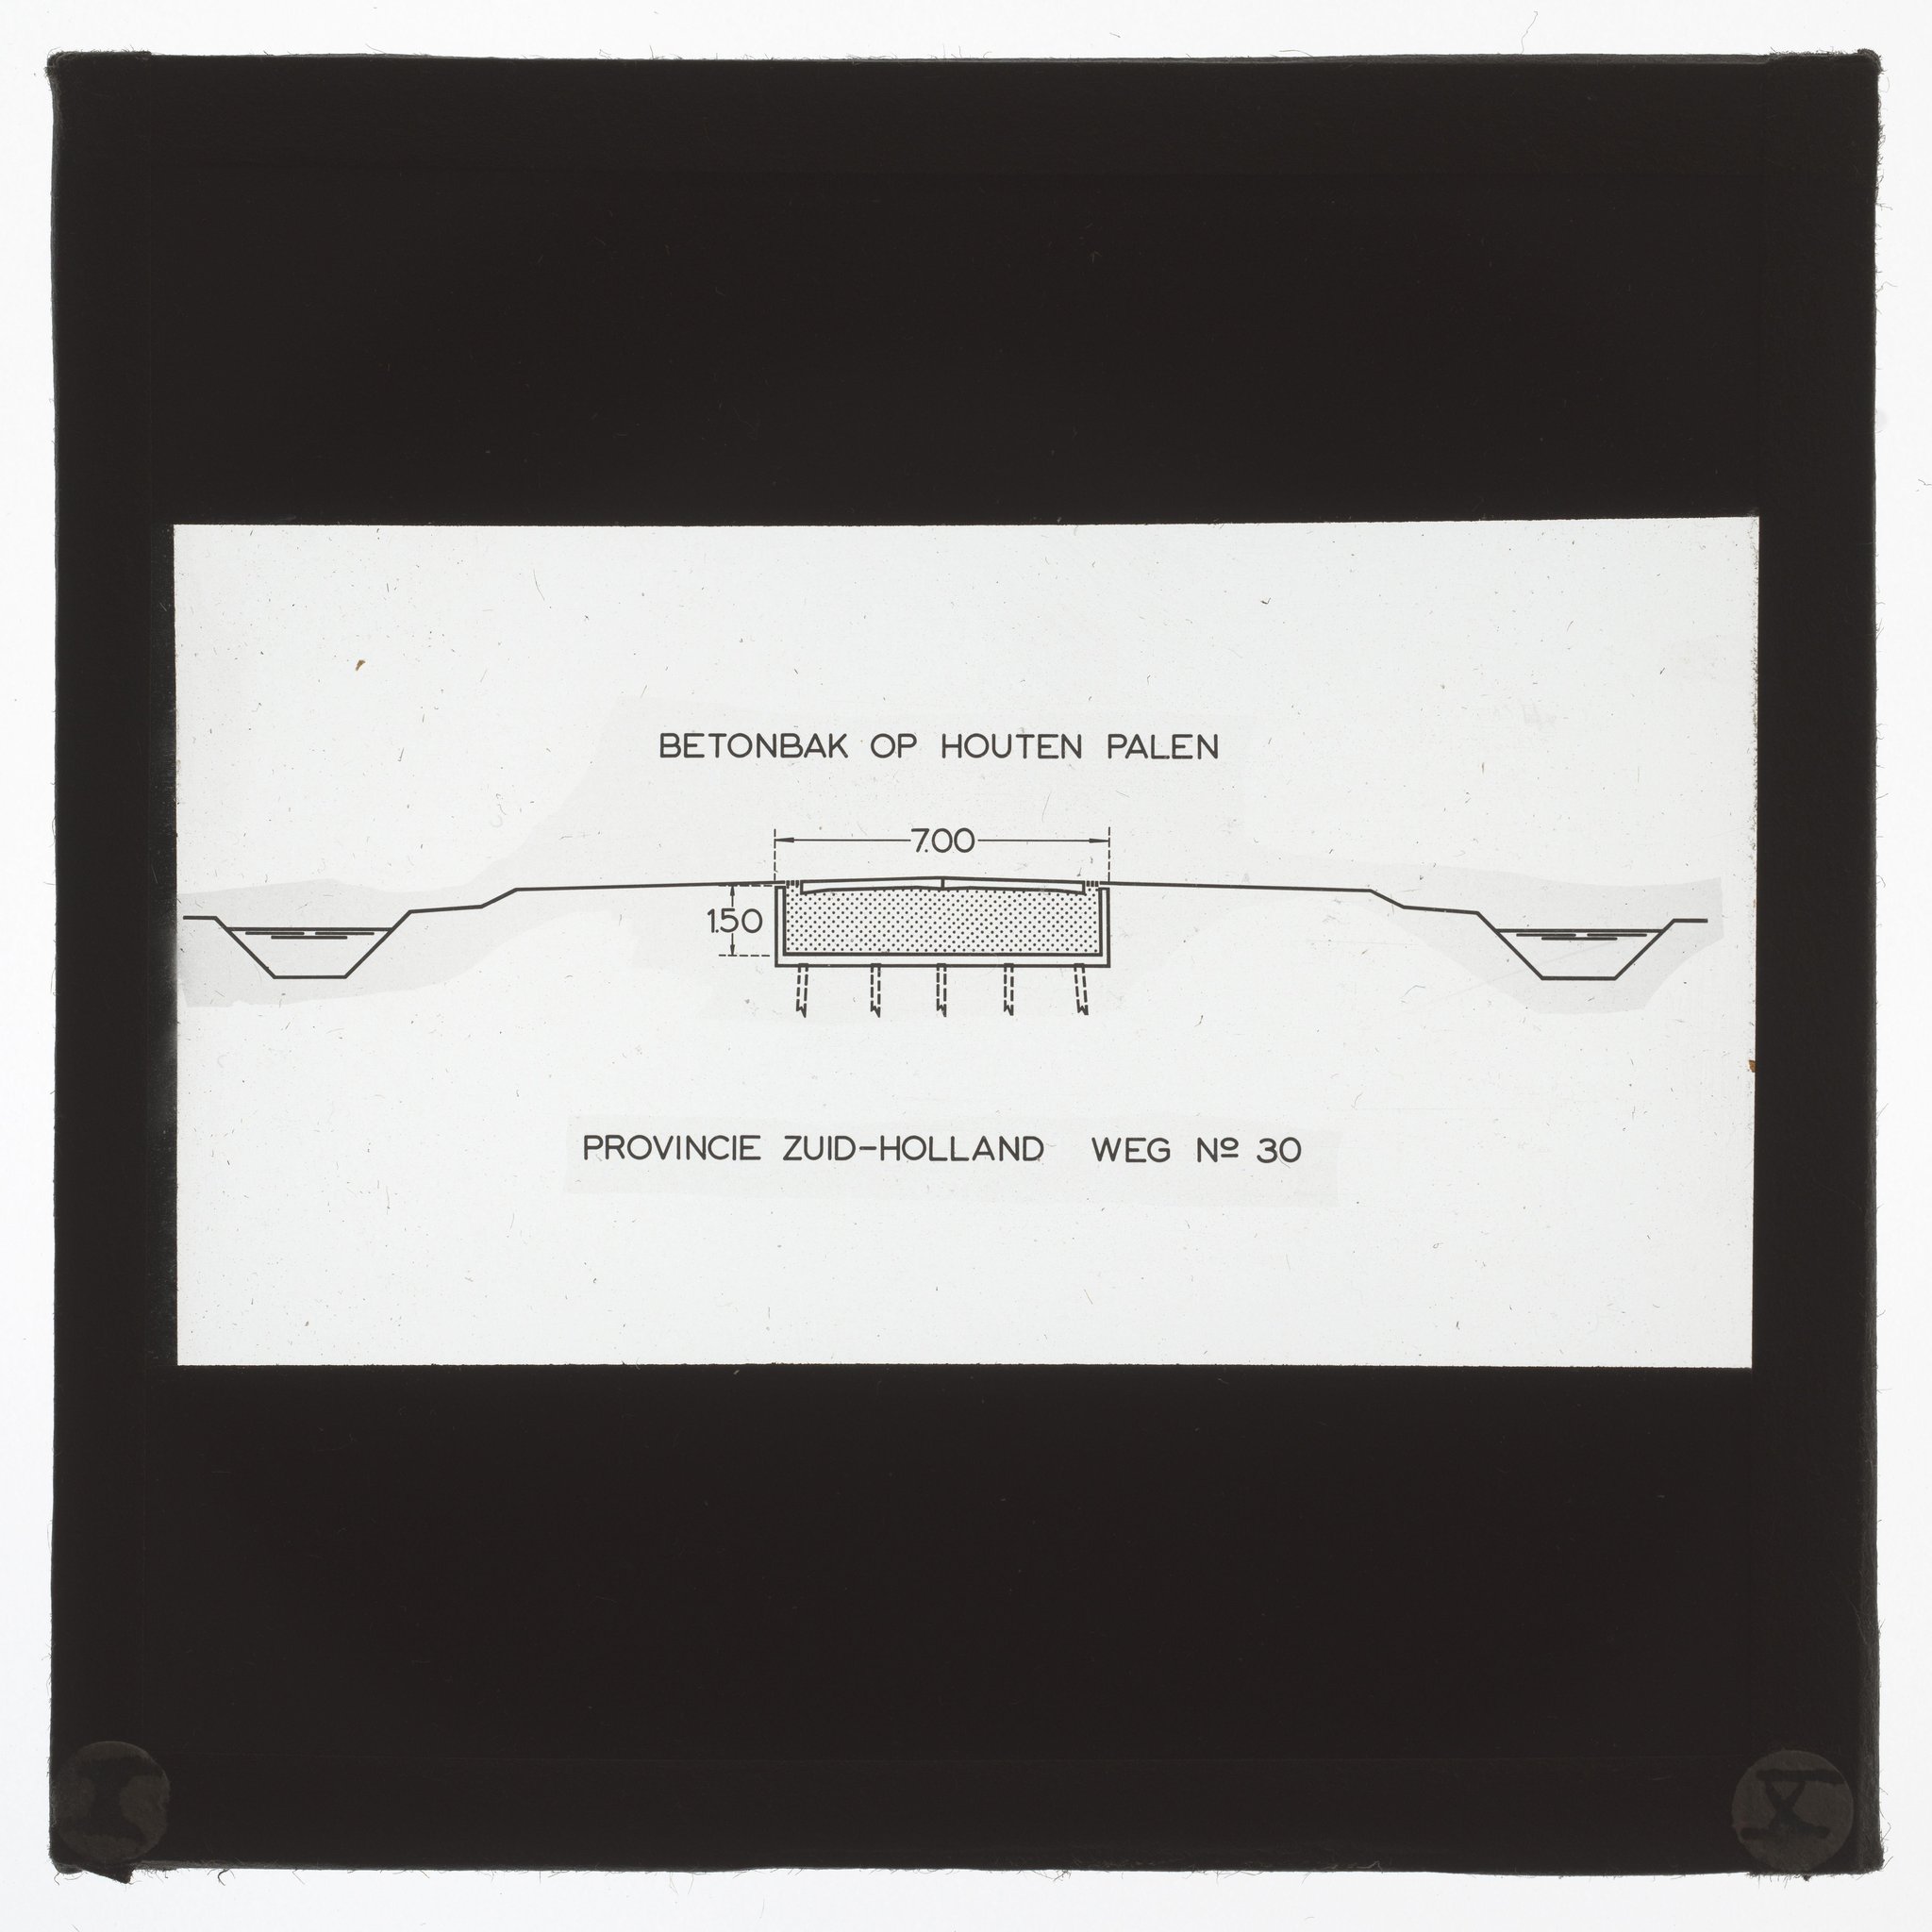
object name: photomechanical print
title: Doorsnede van een betonbak onder een weg in Zuid-Holland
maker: Anonymous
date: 1956-1960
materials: glass, paper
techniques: printing block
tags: statistic diagram, graph; pictorial chart, etc., public road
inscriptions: number: ‘X’